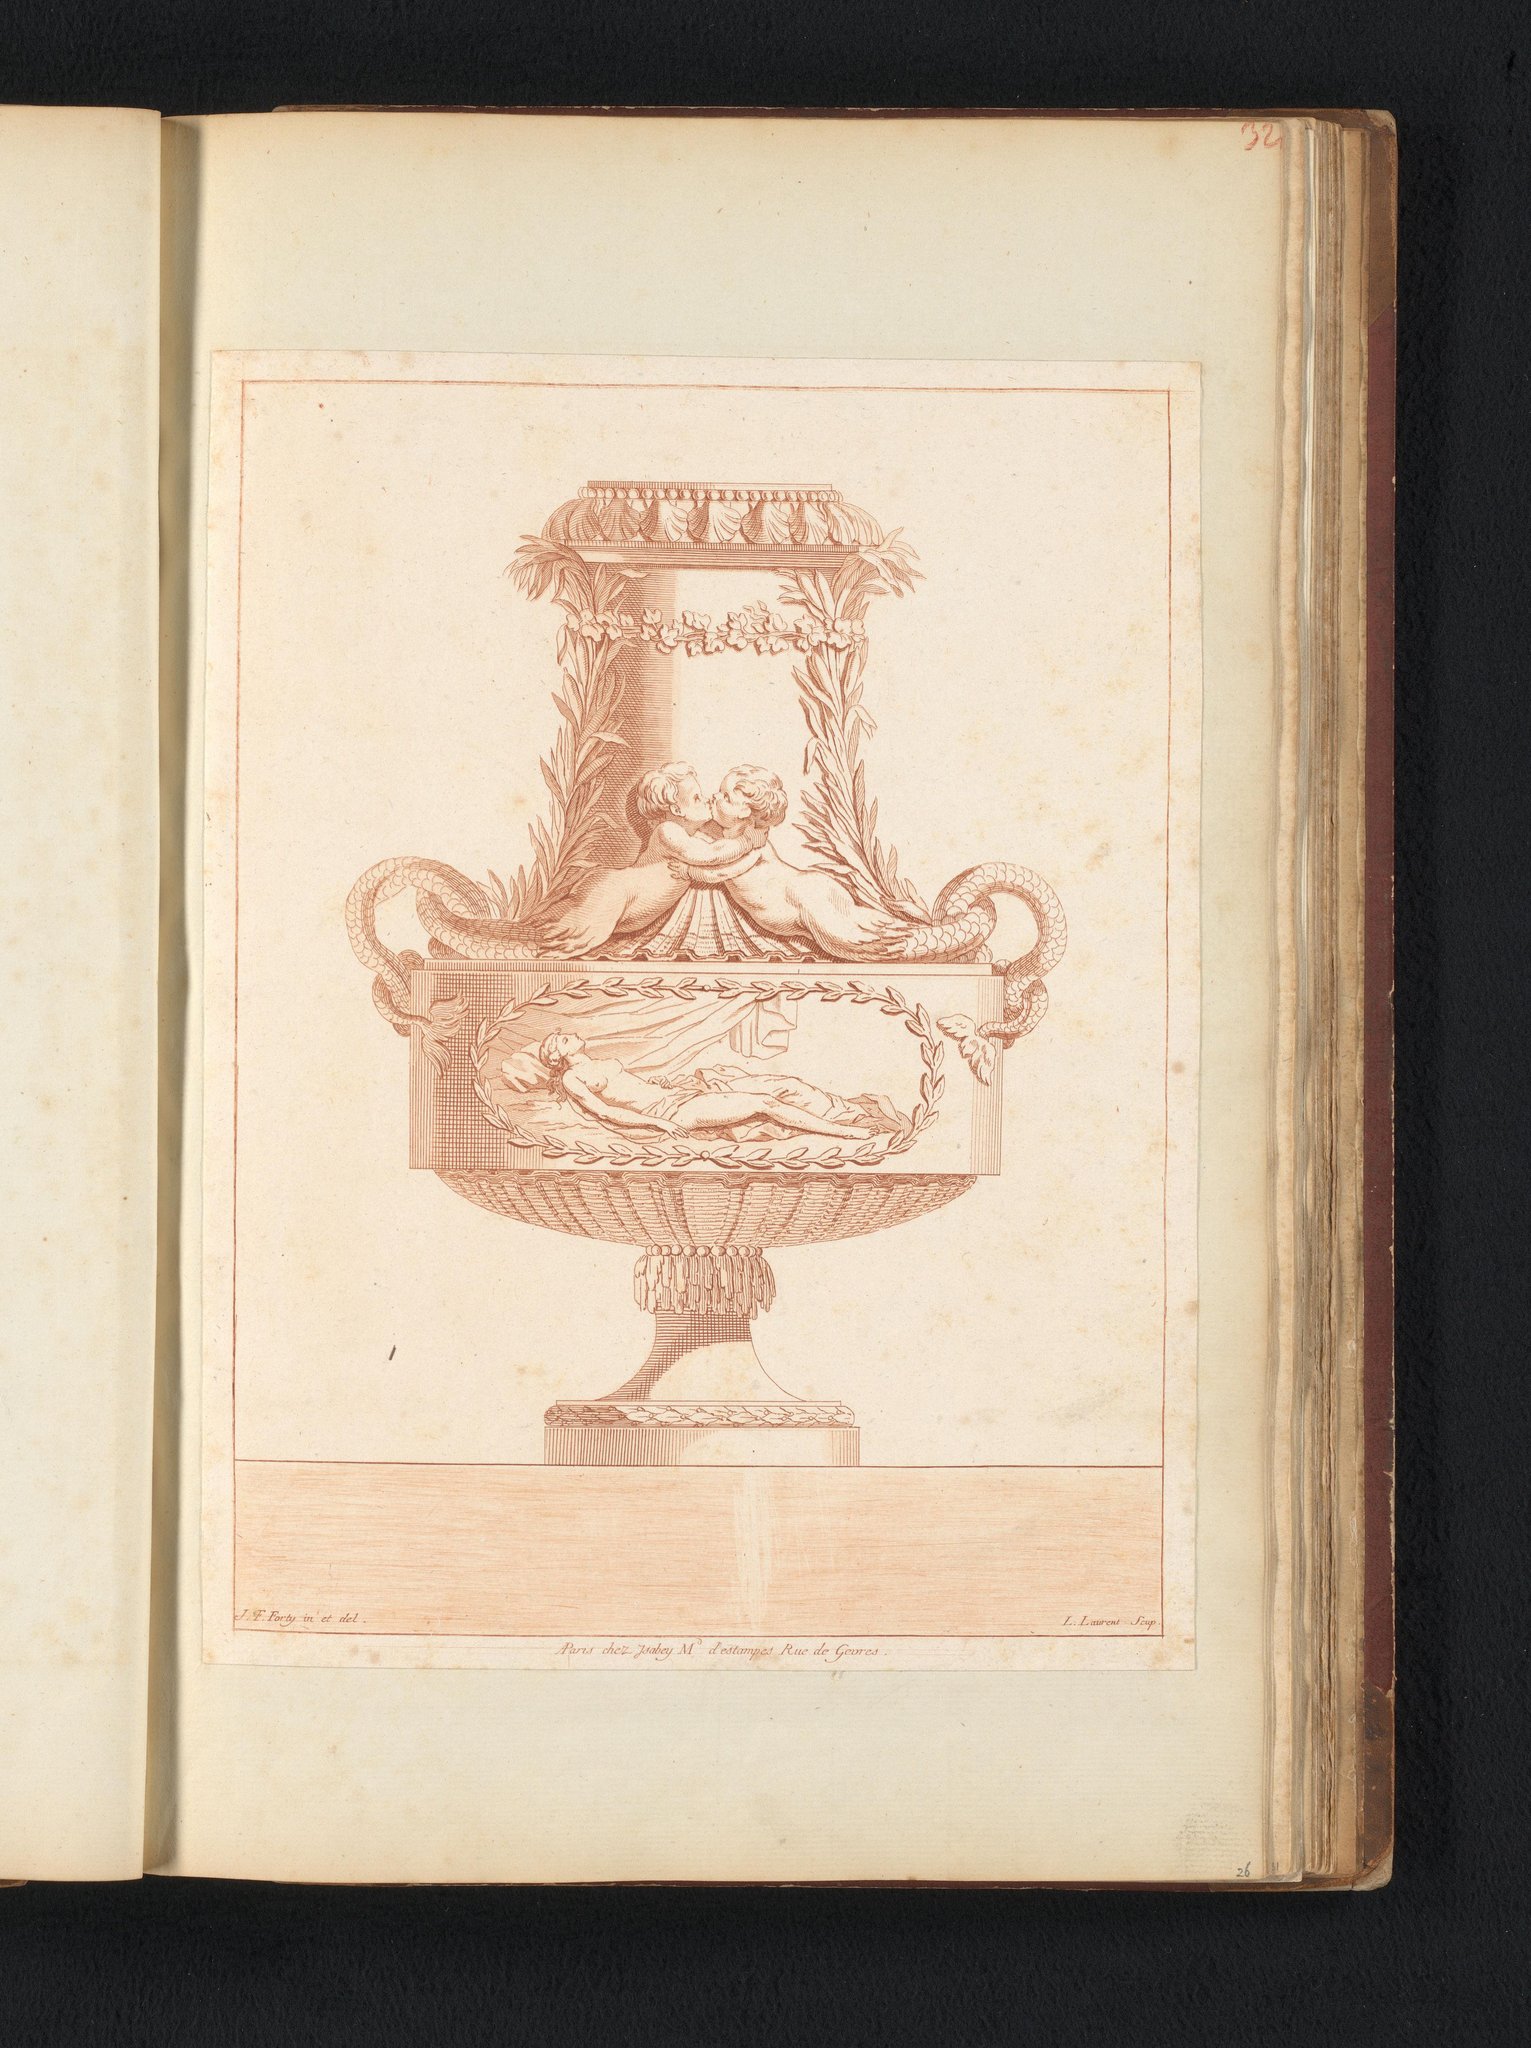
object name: album leaf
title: Vaas`met putti en slapende vrouw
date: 1775-1785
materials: paper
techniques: aquatint, engraving, etching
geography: france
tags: containers, garden vase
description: Vaas`met kussende putti met vissenstaarten en een slapende vrouw. Onderdeel van het tweede van twee albums met ingeplakte prenten en tekeningen te dienen als tekenvoorbeelden.